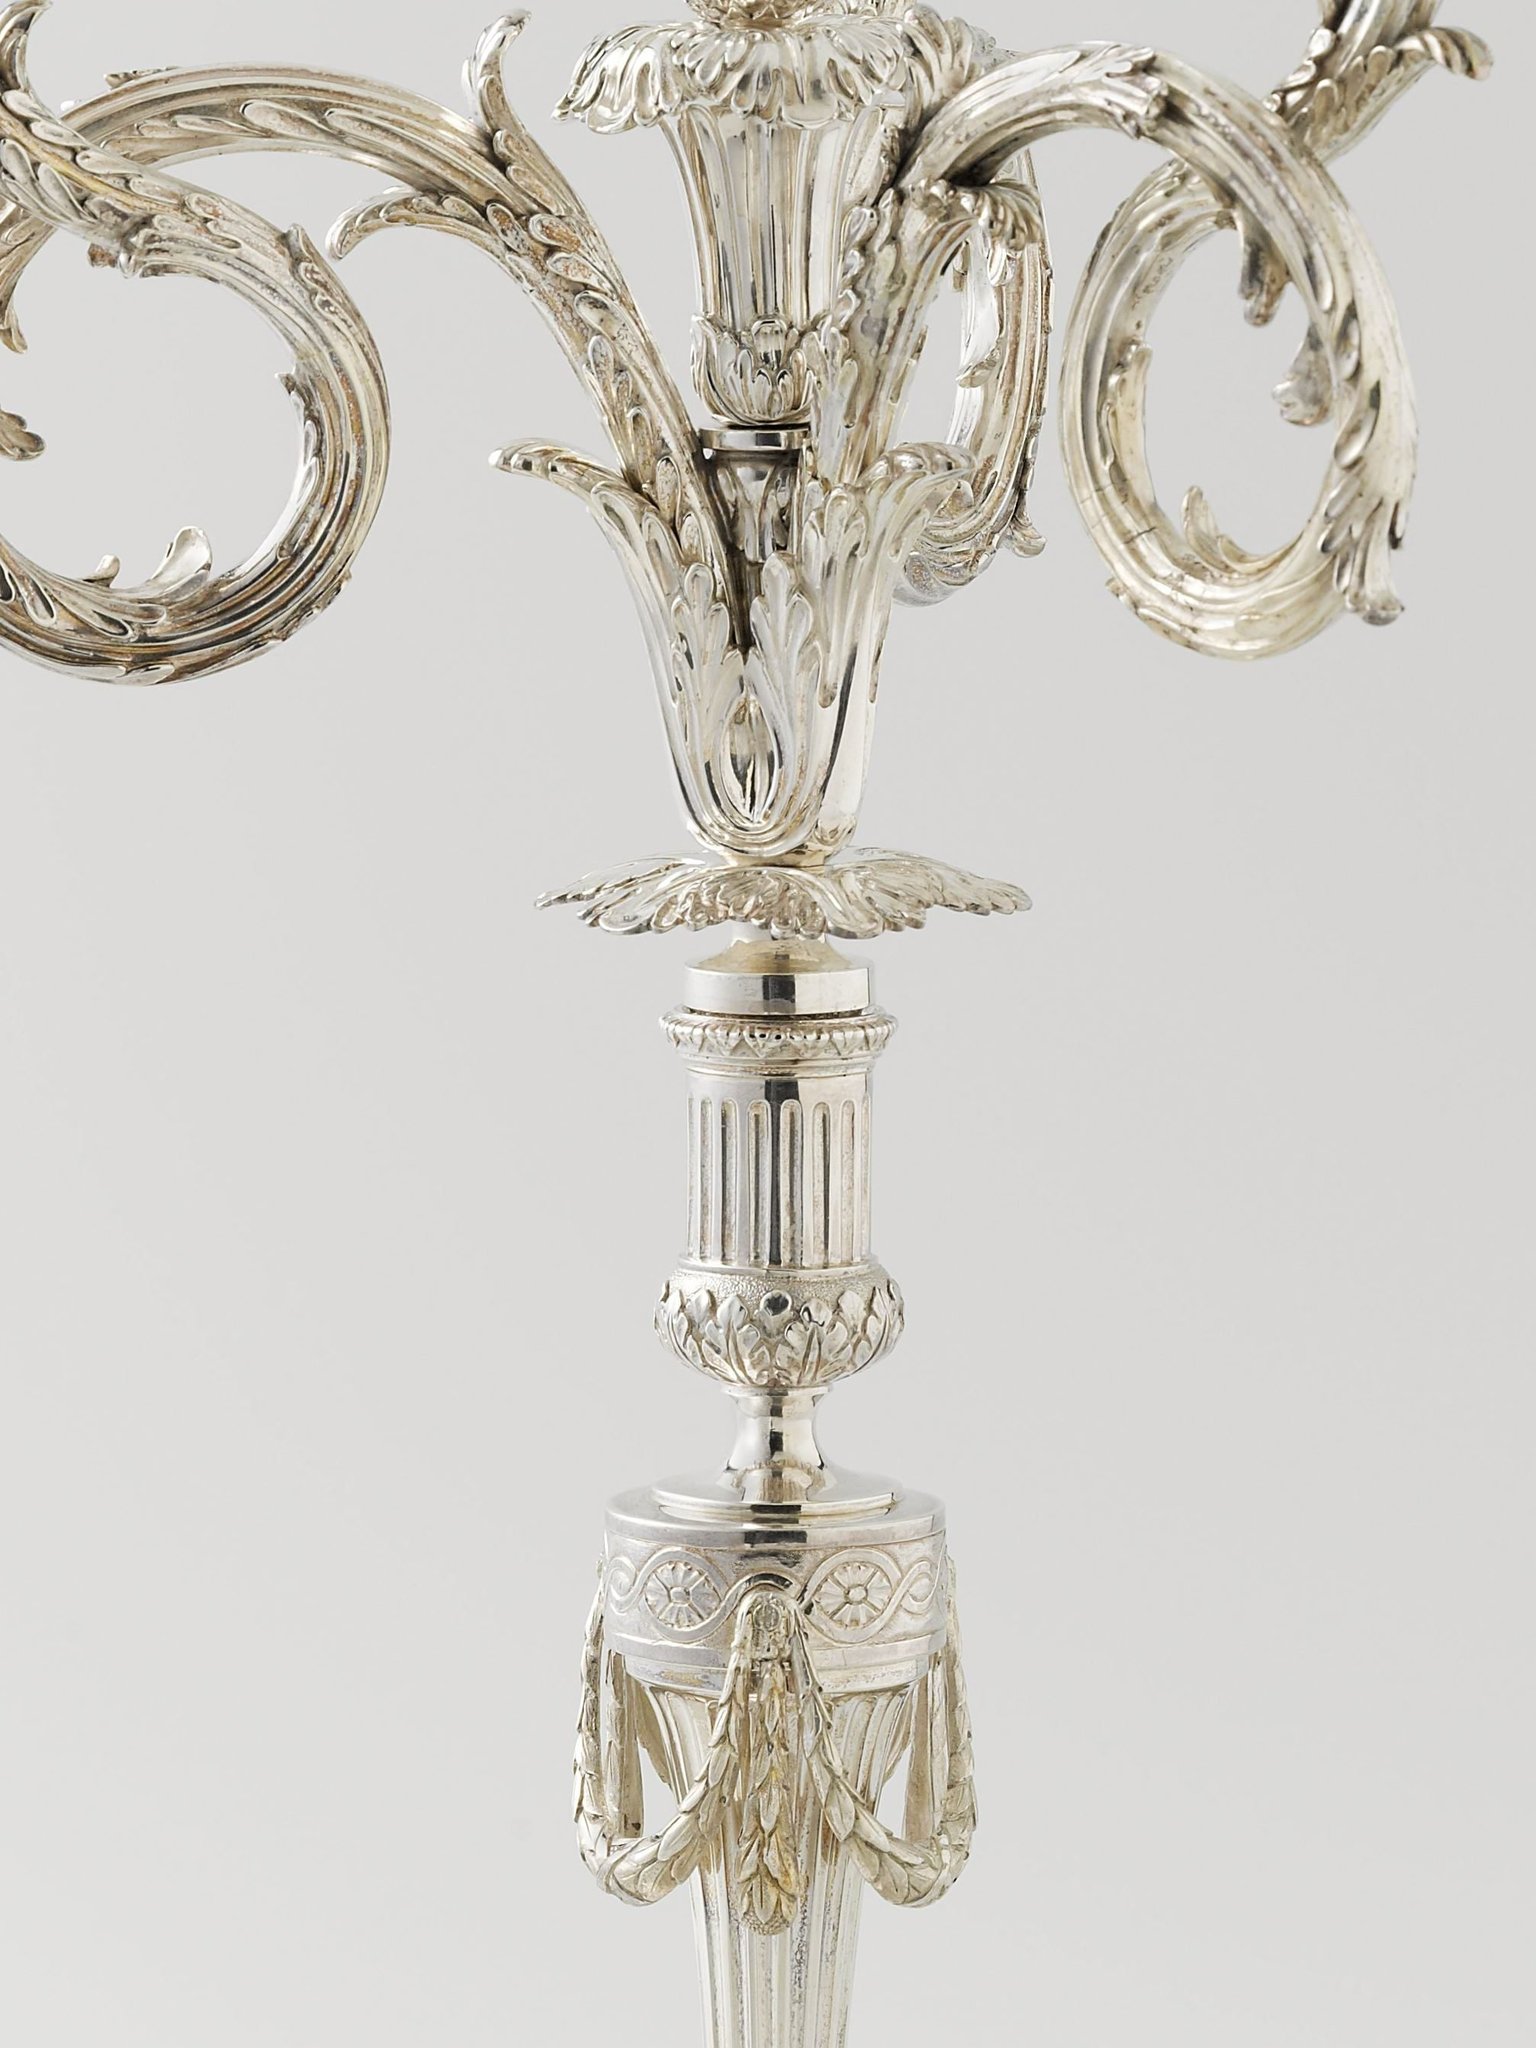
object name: candelabrum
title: Kandelaber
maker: cornelis knuysting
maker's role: silversmith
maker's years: 1730-1812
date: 1789-1791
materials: silver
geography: rotterdam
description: Two candlesticks and two candelabra. Silver. Rotterdam, 1789 and 1791, by Cornelis Knuysting. On loan from the Remonstrant Reformed Church, Amsterdam.